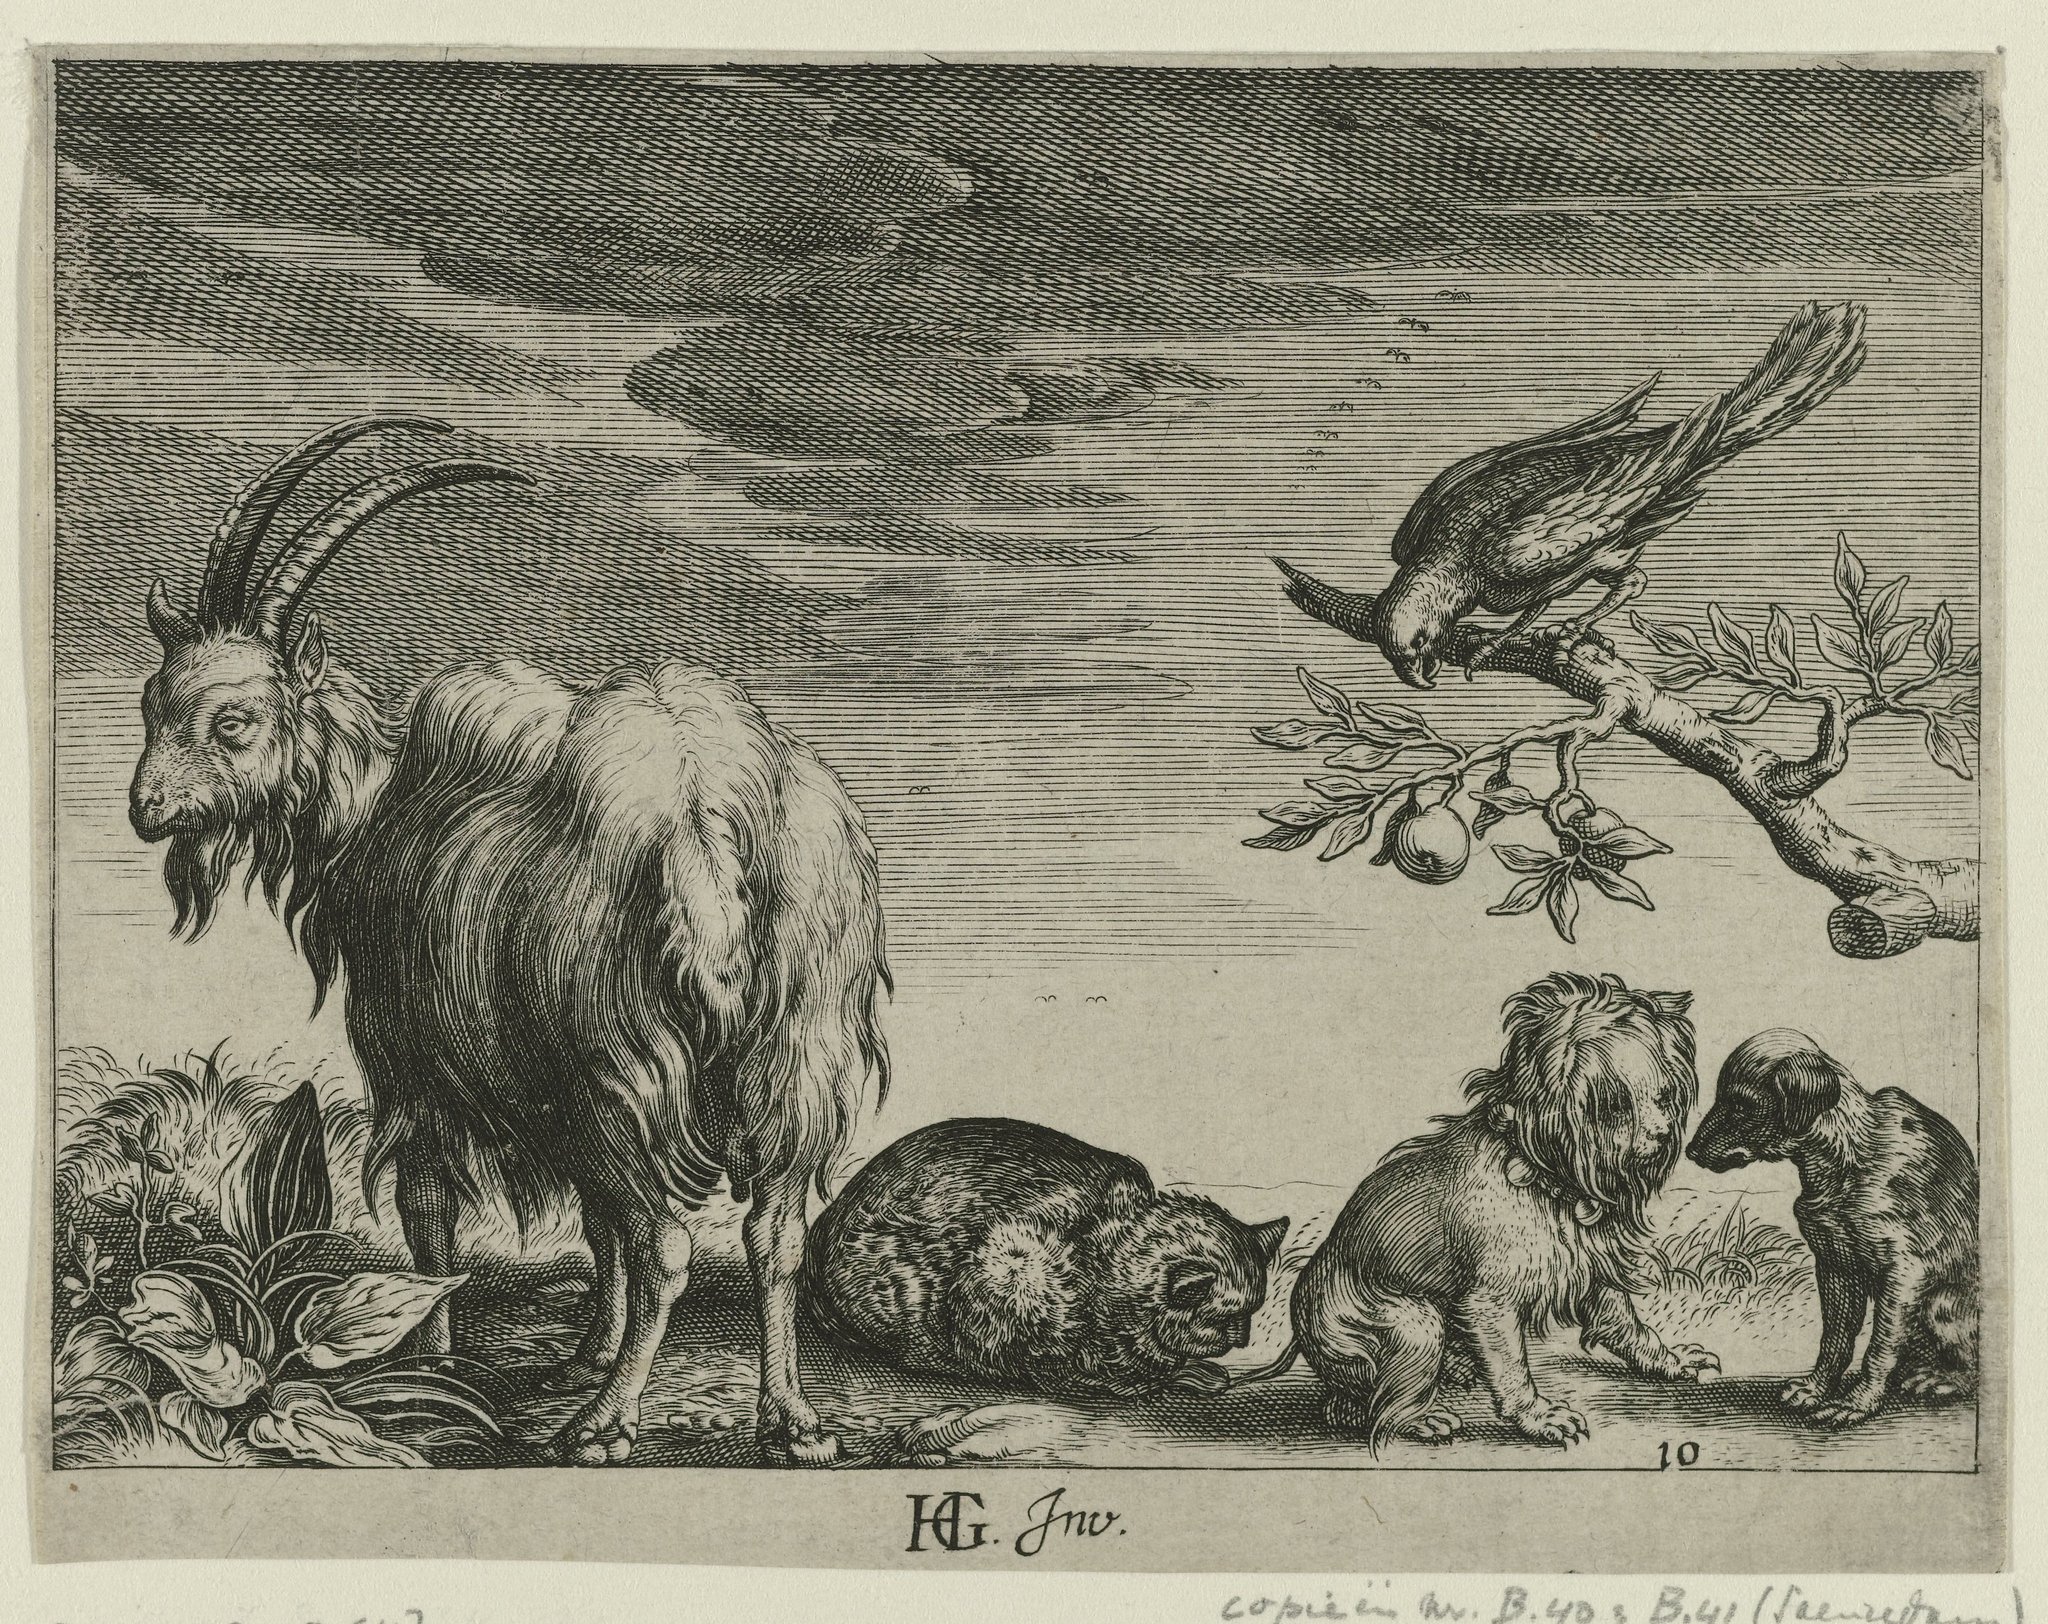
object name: print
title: Geit, kat, twee honden en een papegaai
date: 1597-1667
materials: paper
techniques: engraving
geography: haarlem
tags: cat, ornamental birds: parrot, he-goat, billy-goat, dog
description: Van links naar rechts: Geit, kat, twee honden en een papegaai op een tak met een appel.